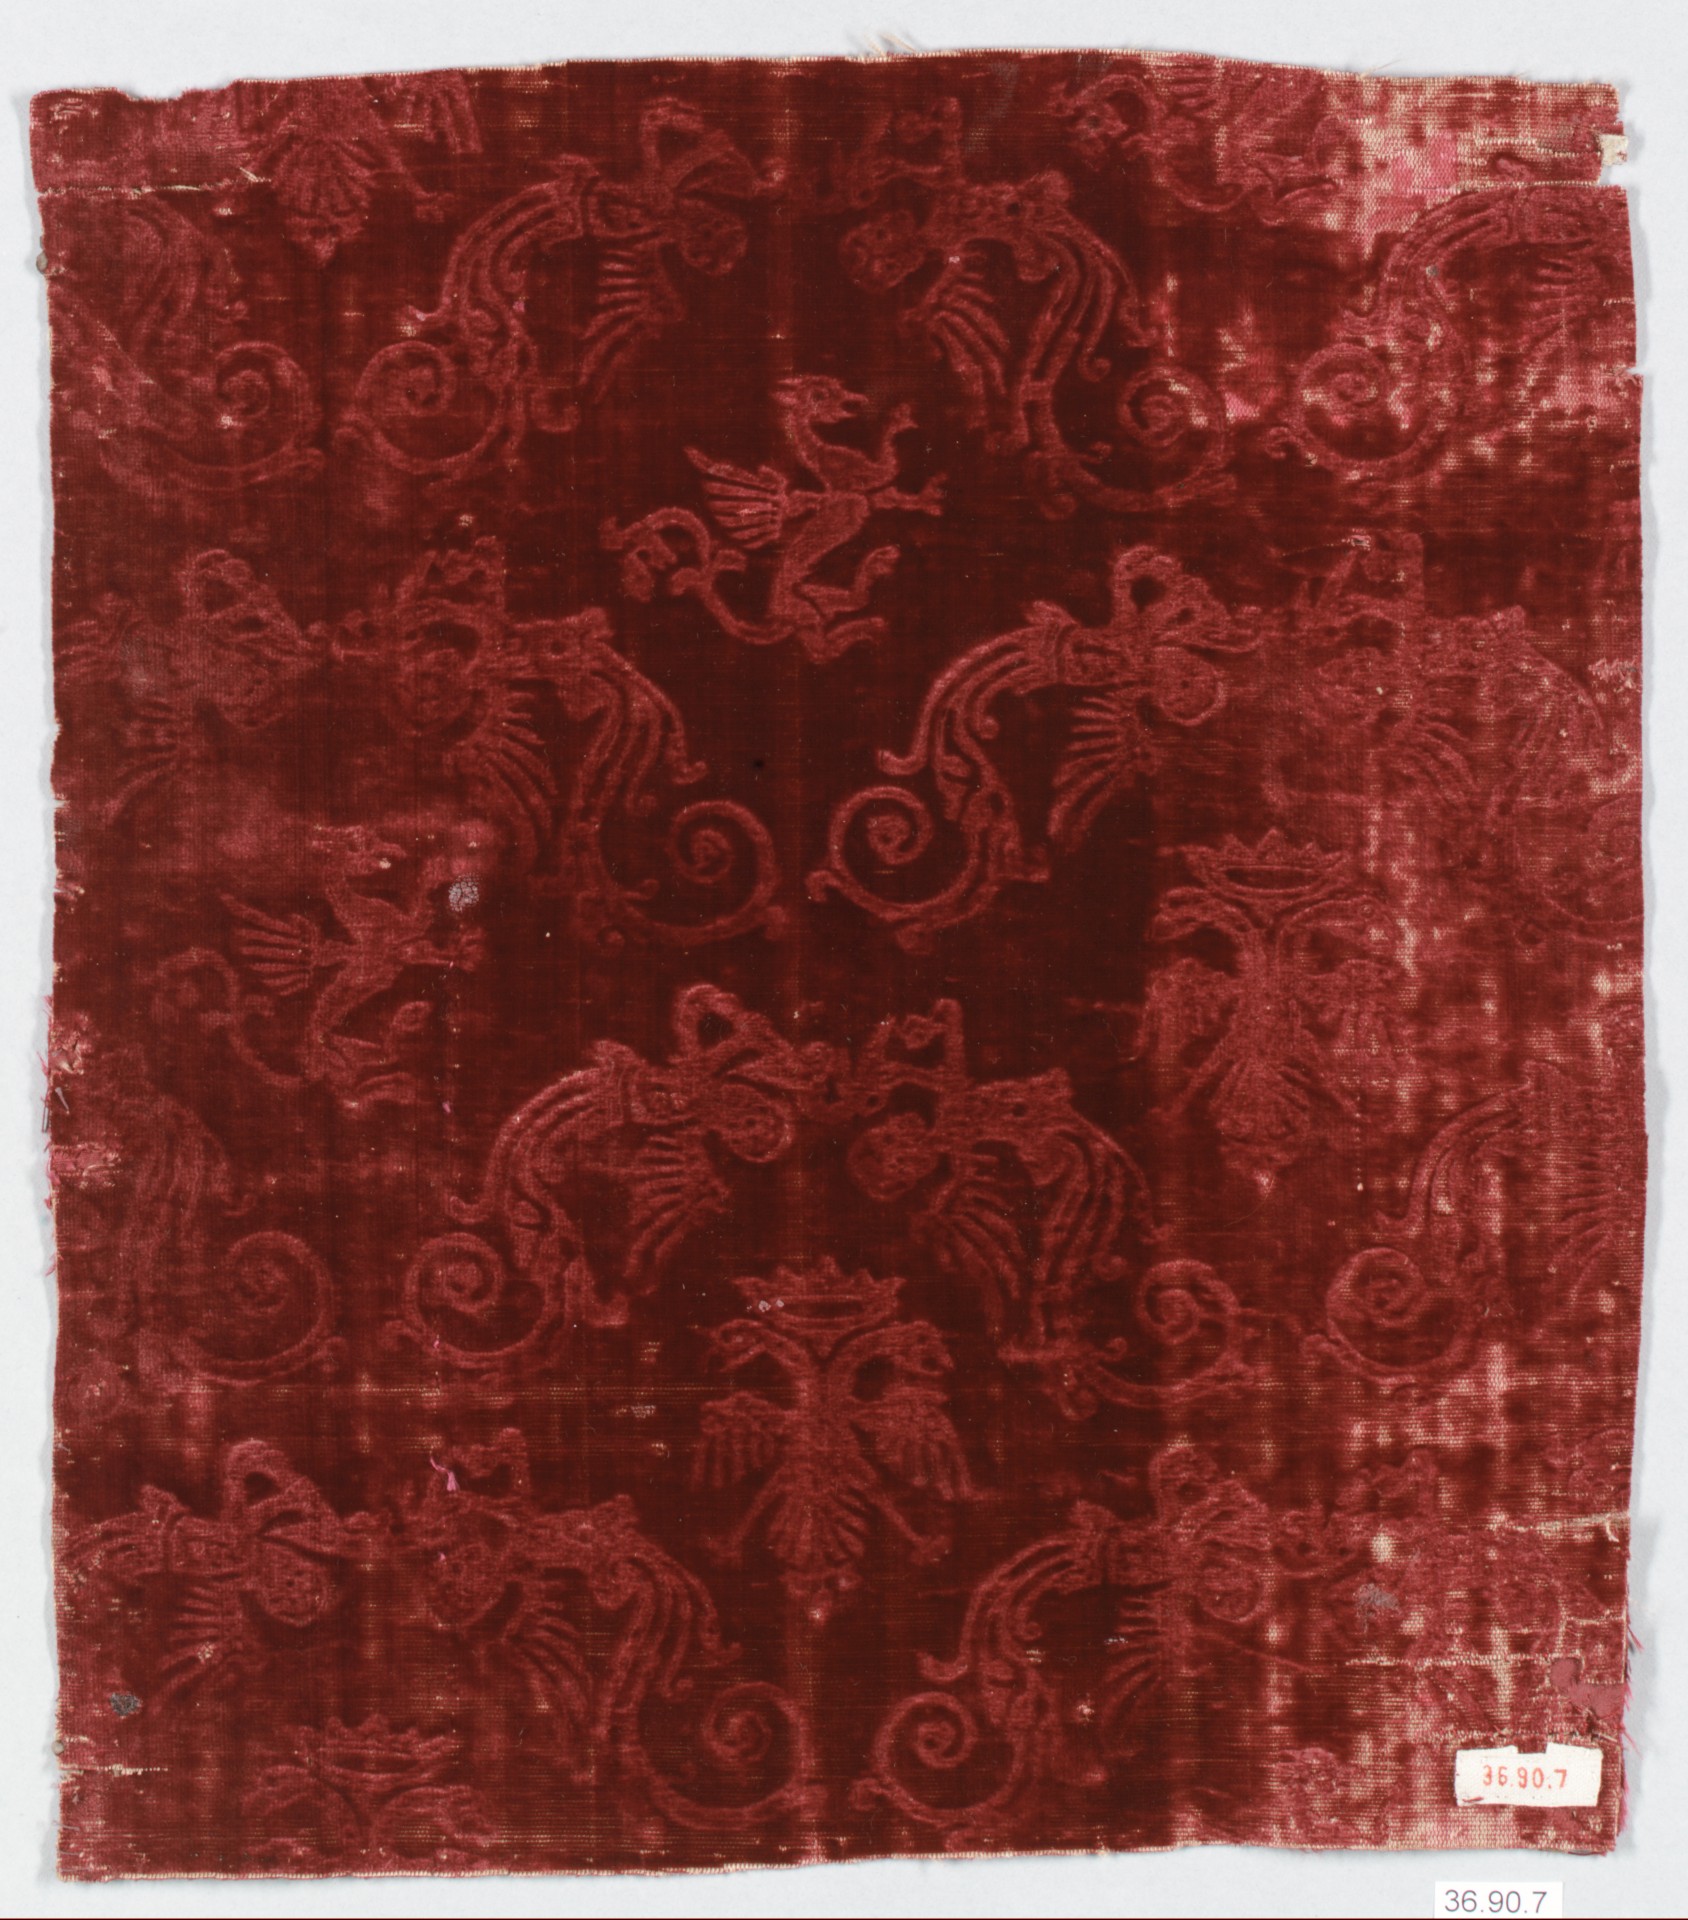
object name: piece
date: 1501-1600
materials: silk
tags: eagles,griffins